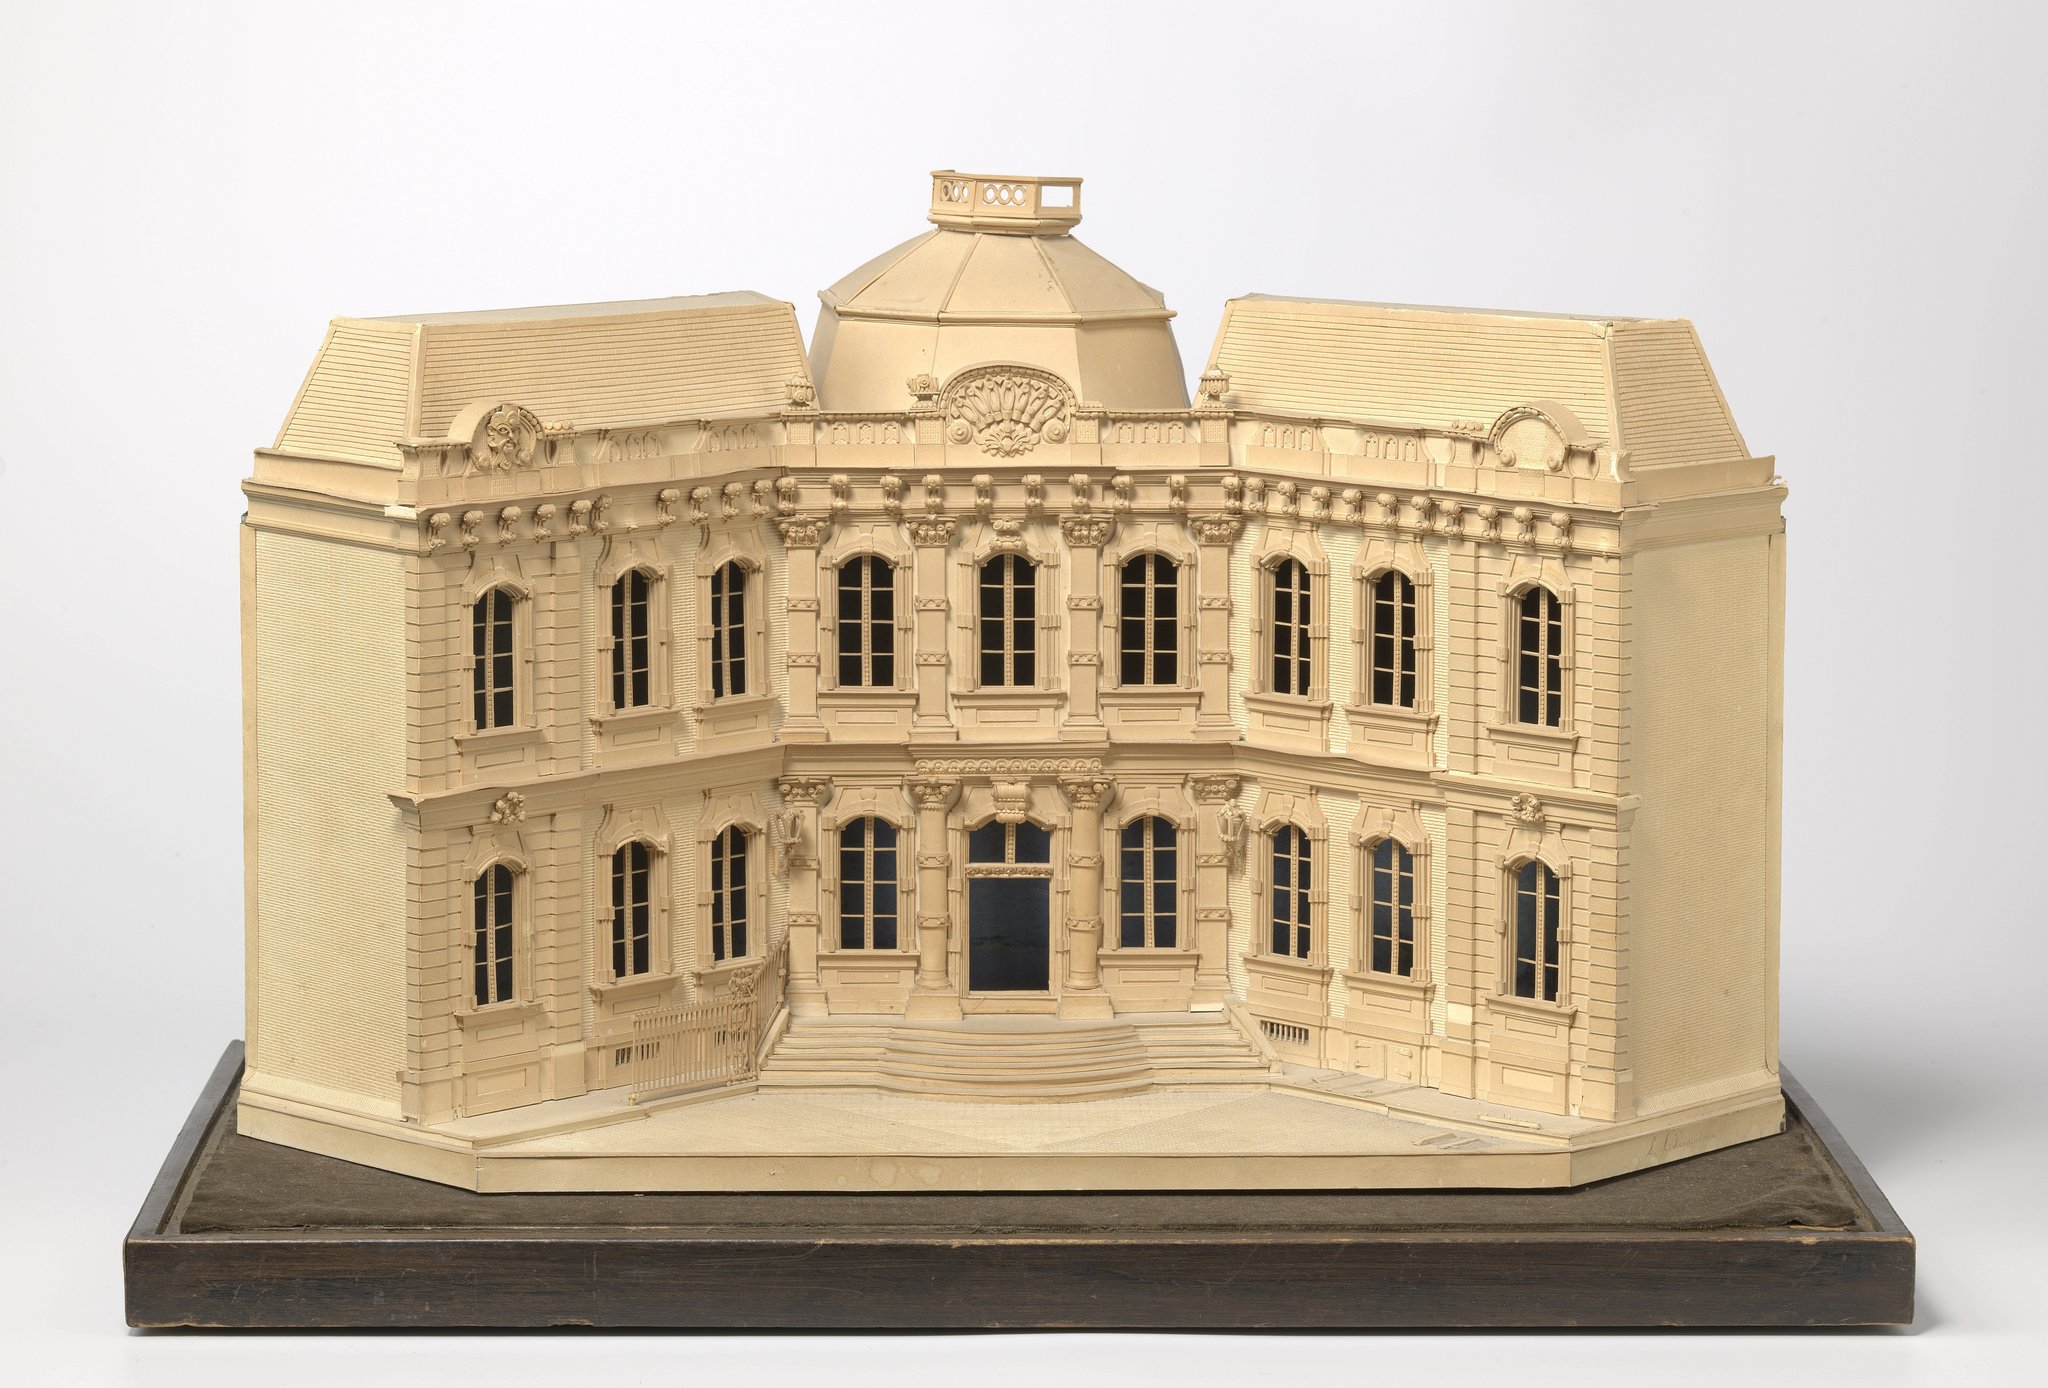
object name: maquette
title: Papieren model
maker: l. a. van den ende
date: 1800-1875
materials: paper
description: Paleis van de Prins van Oranje. Model in wit papier, in een glazen kast. De glazen kast ontbreekt.